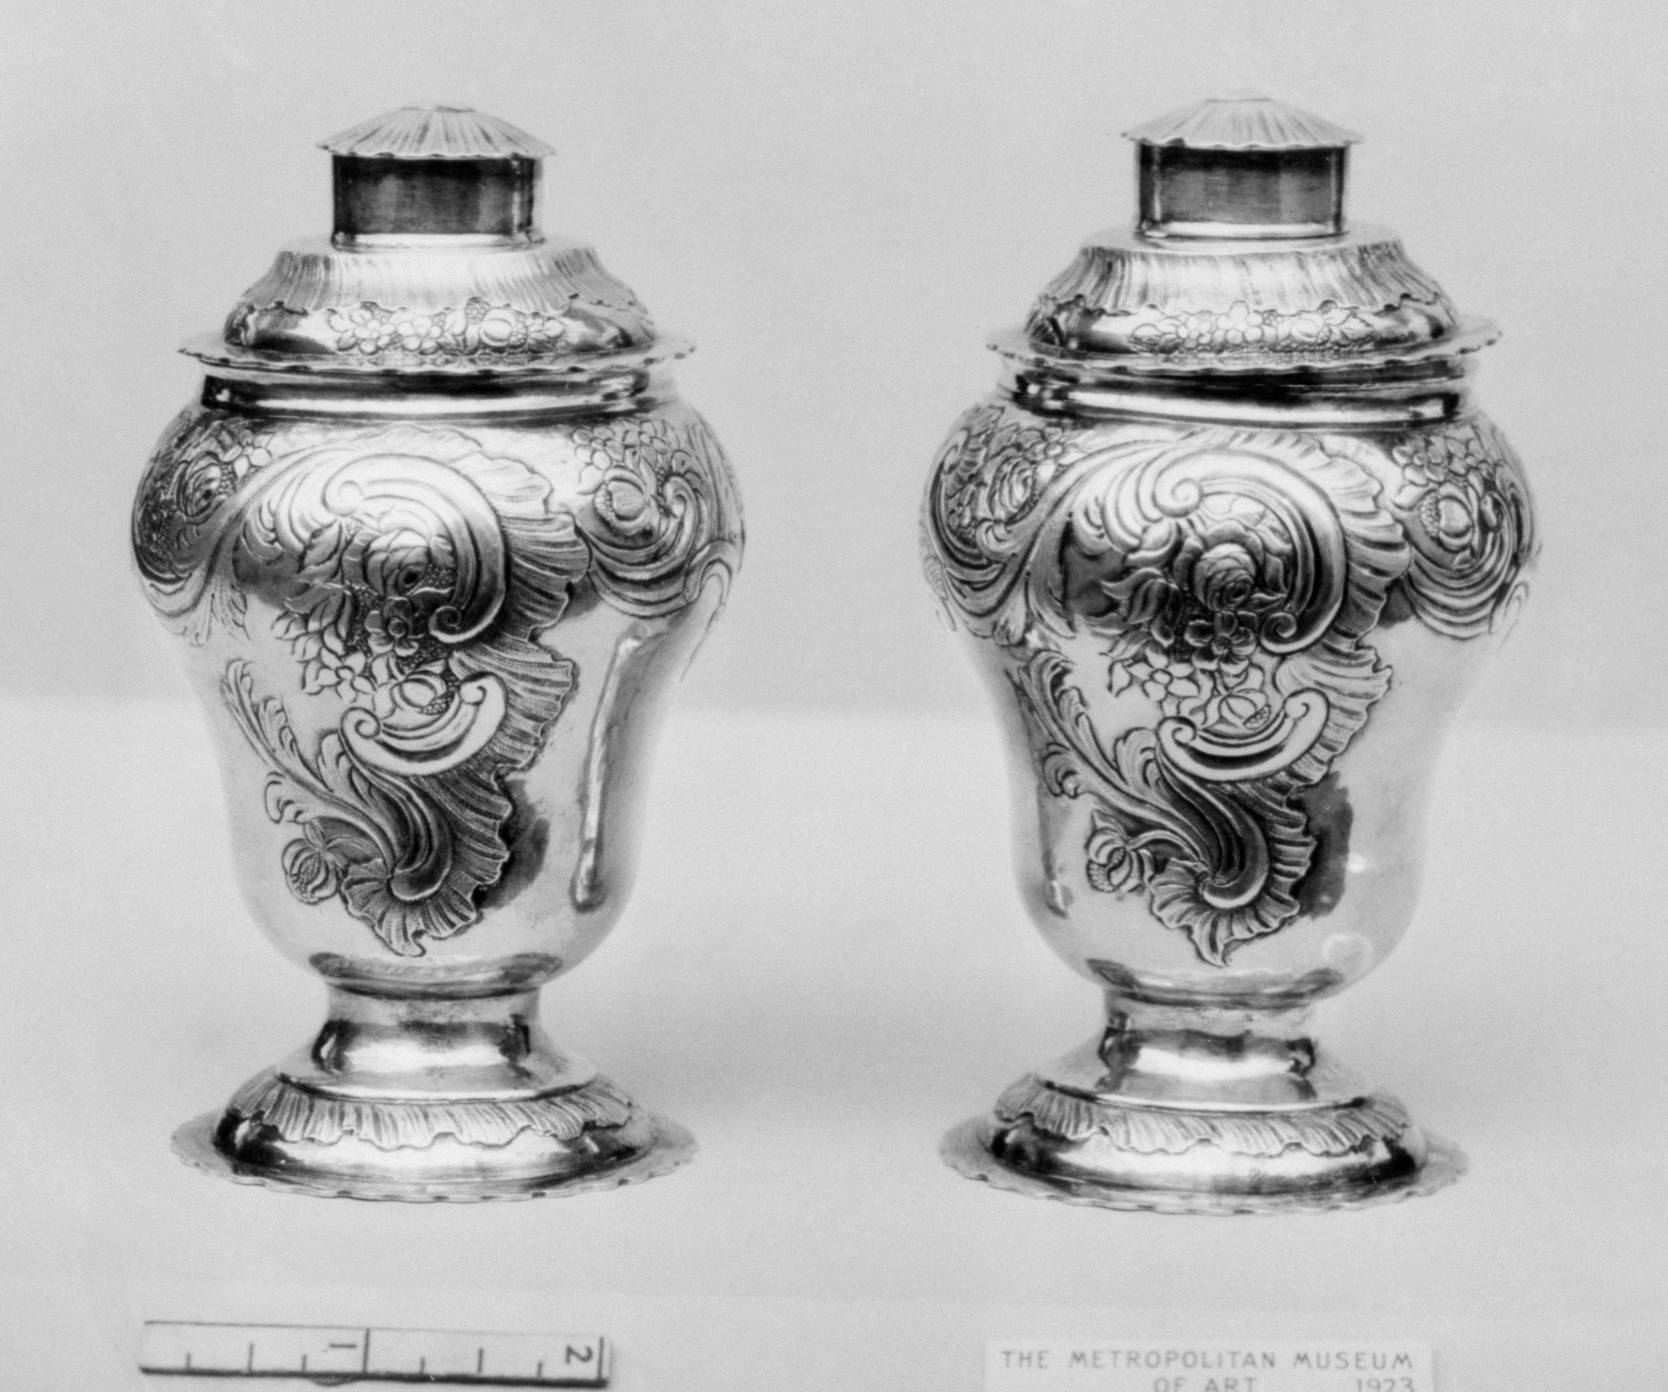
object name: tea caddy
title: Tea caddy (one of a pair)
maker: christopher jonsen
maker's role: maker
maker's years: 1734-1775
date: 1758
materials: silver